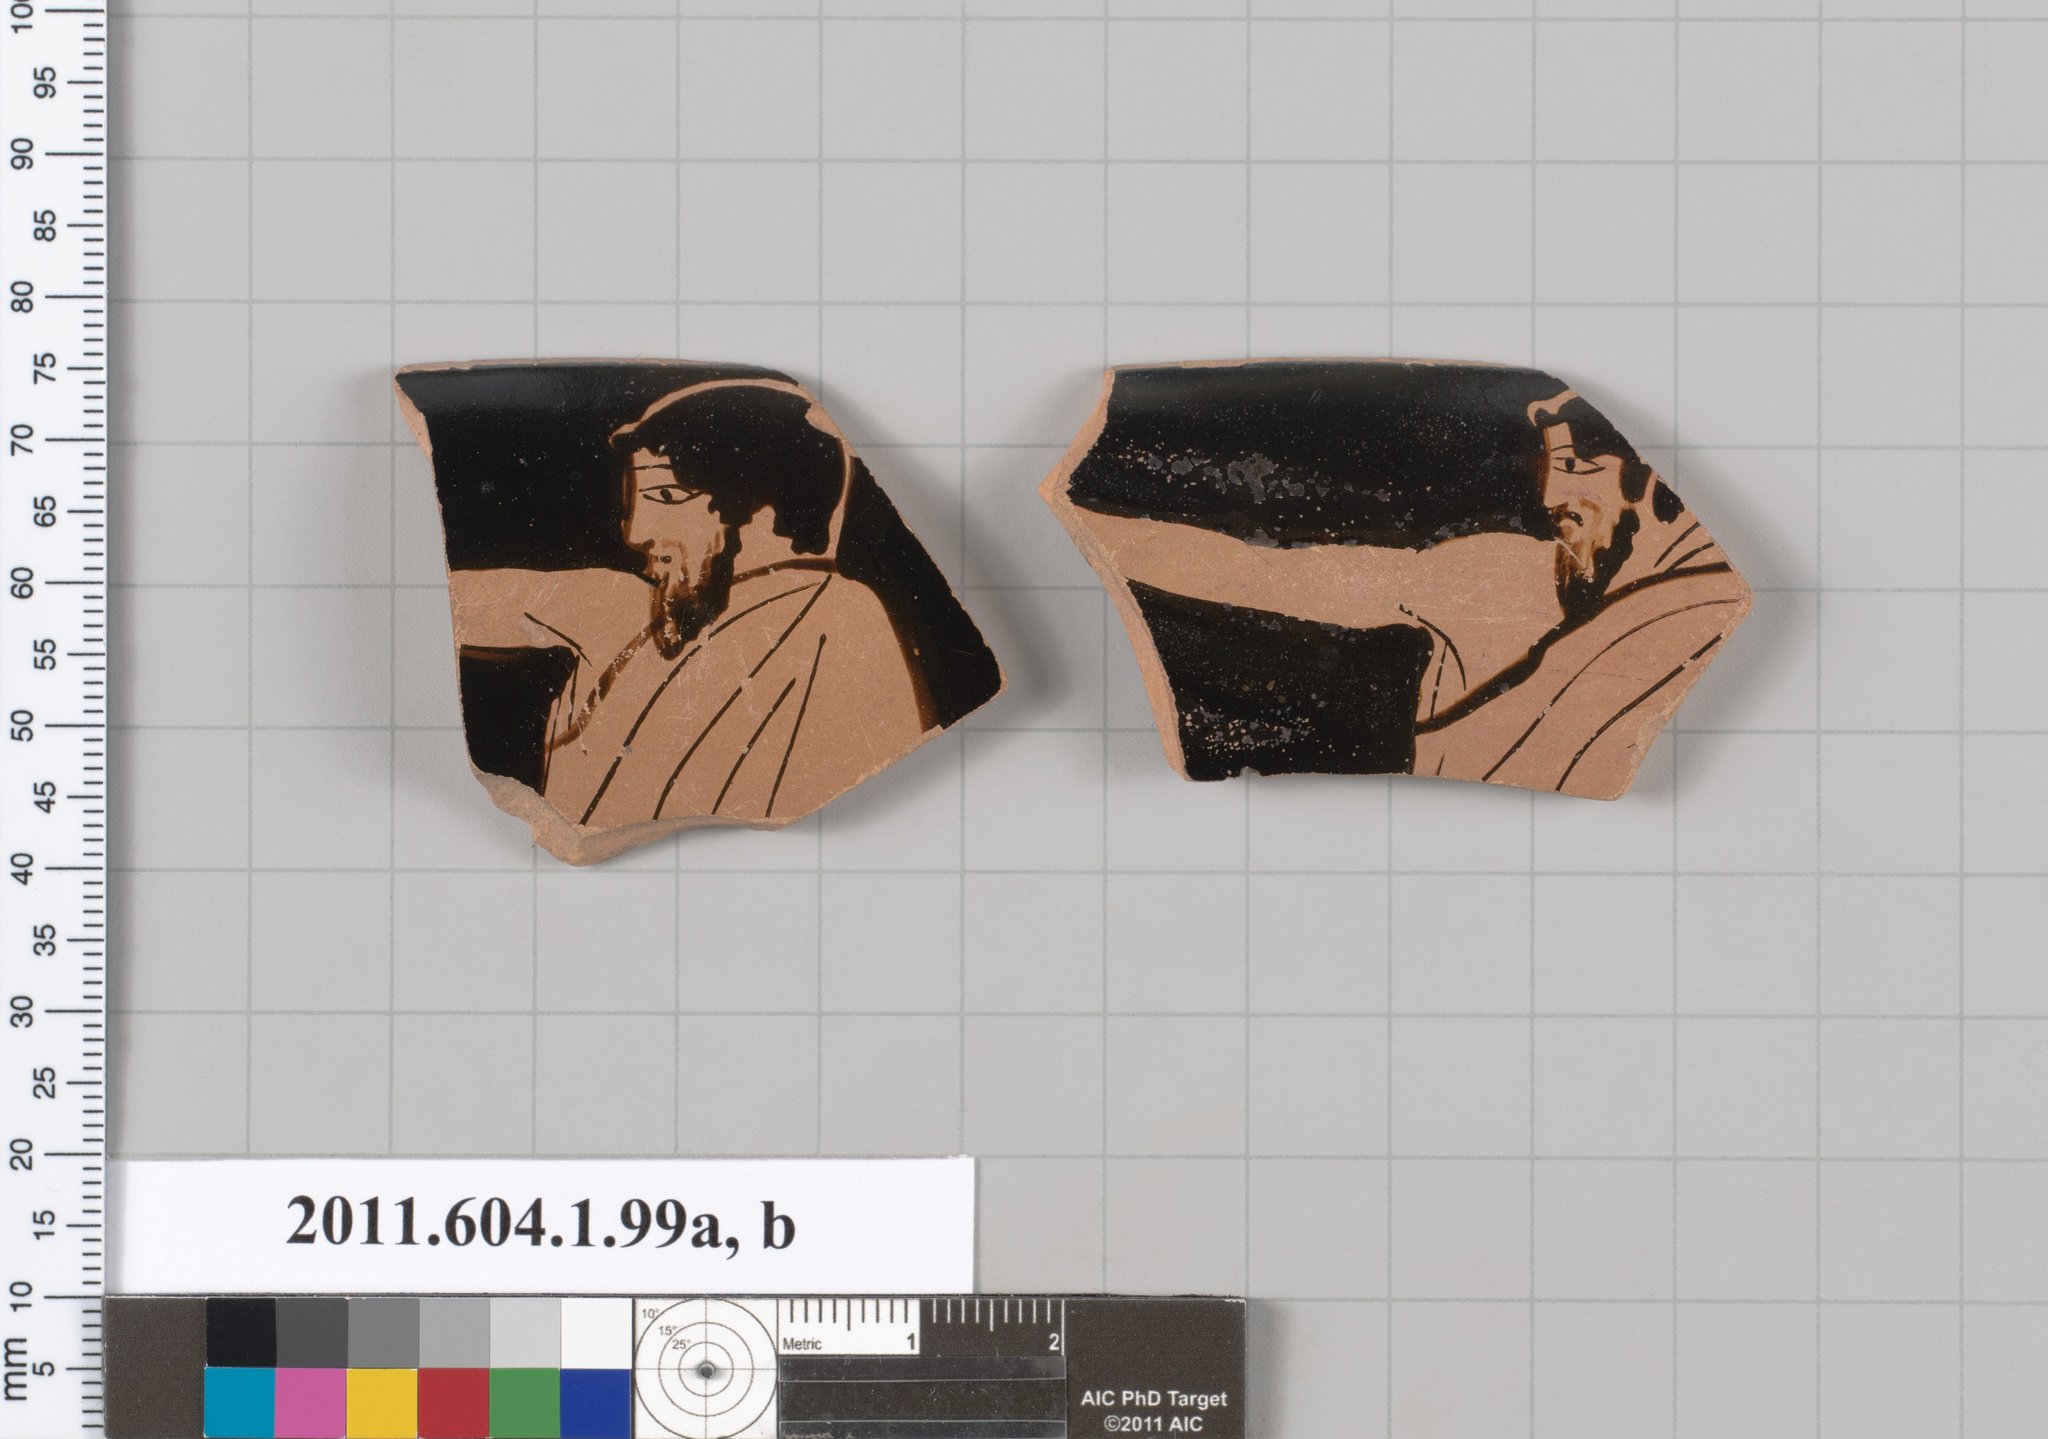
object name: kylix fragment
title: Terracotta rim fragments of a kylix (drinking cup)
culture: greek, attic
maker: painter of london d 12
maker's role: artist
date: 475-451 BCE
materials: terracotta